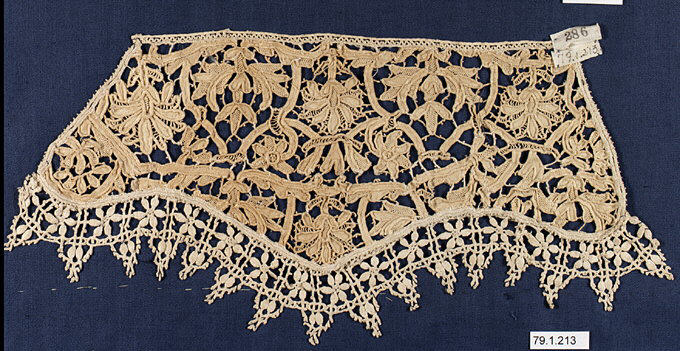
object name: cuff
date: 1667-1700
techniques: lace